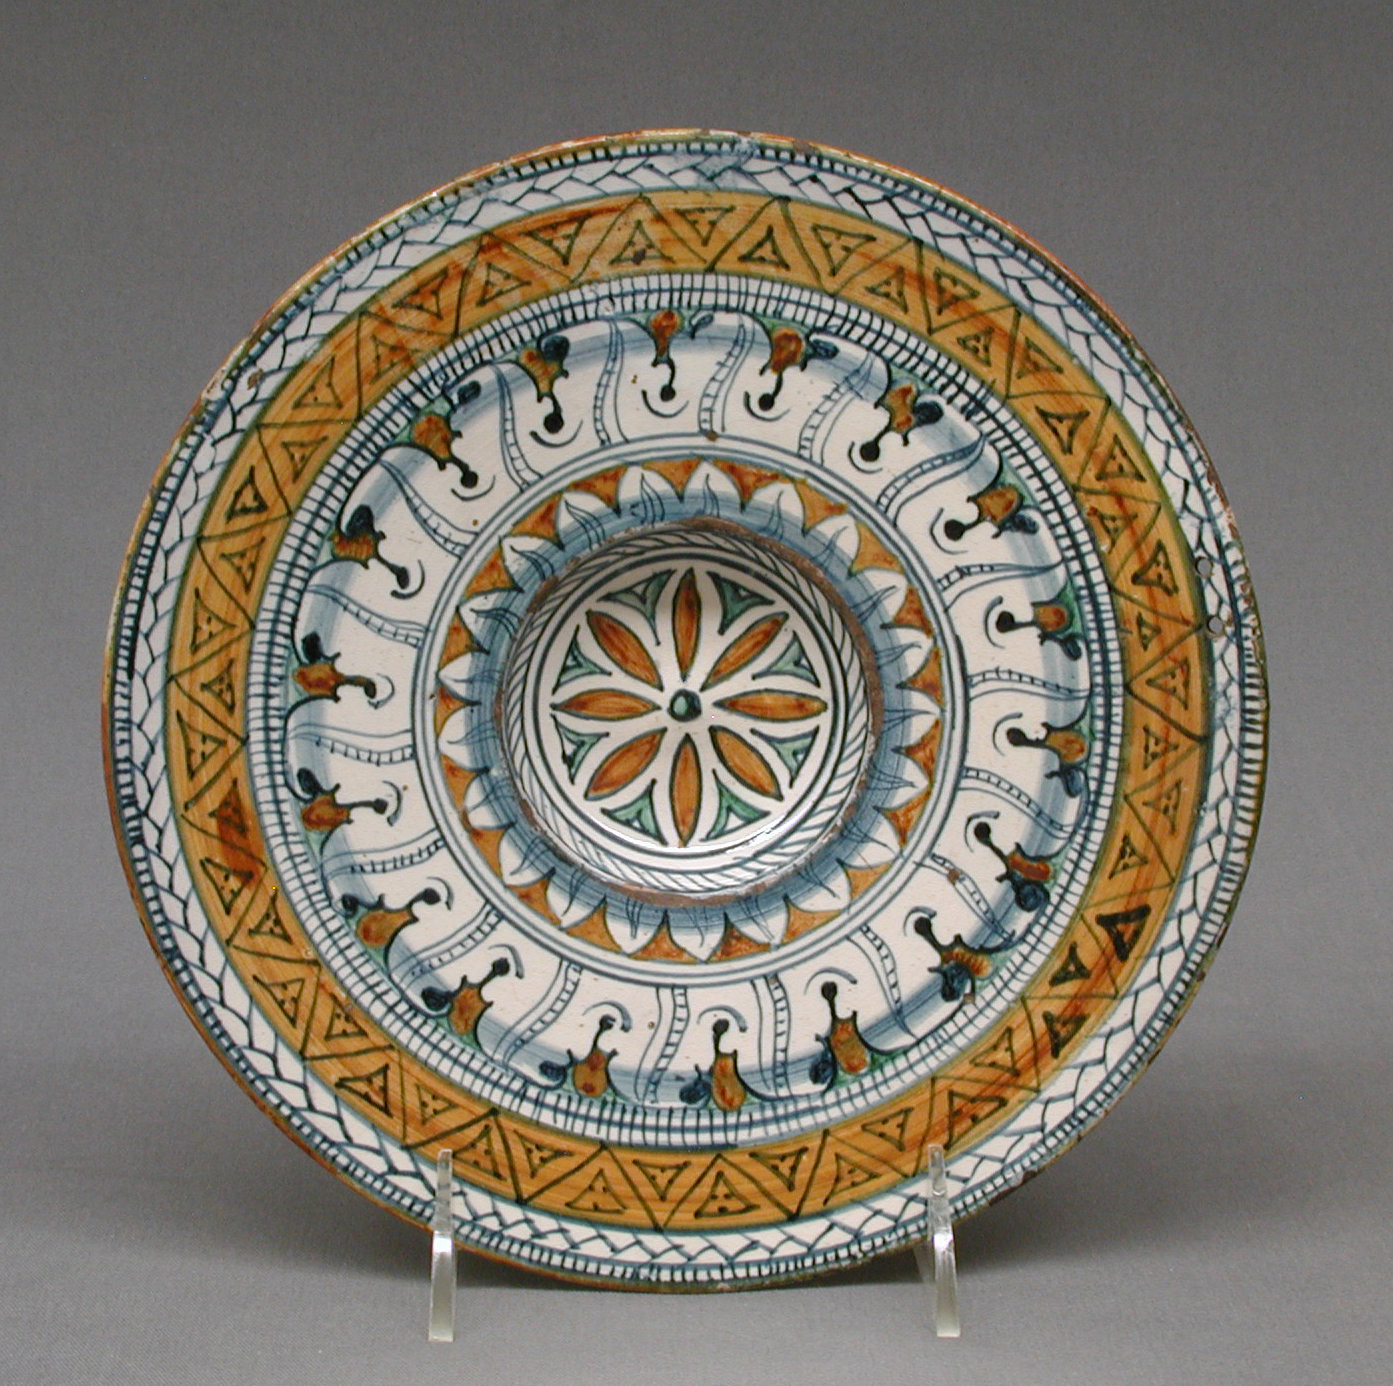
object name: dish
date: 1500-1510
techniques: maiolica, glazing